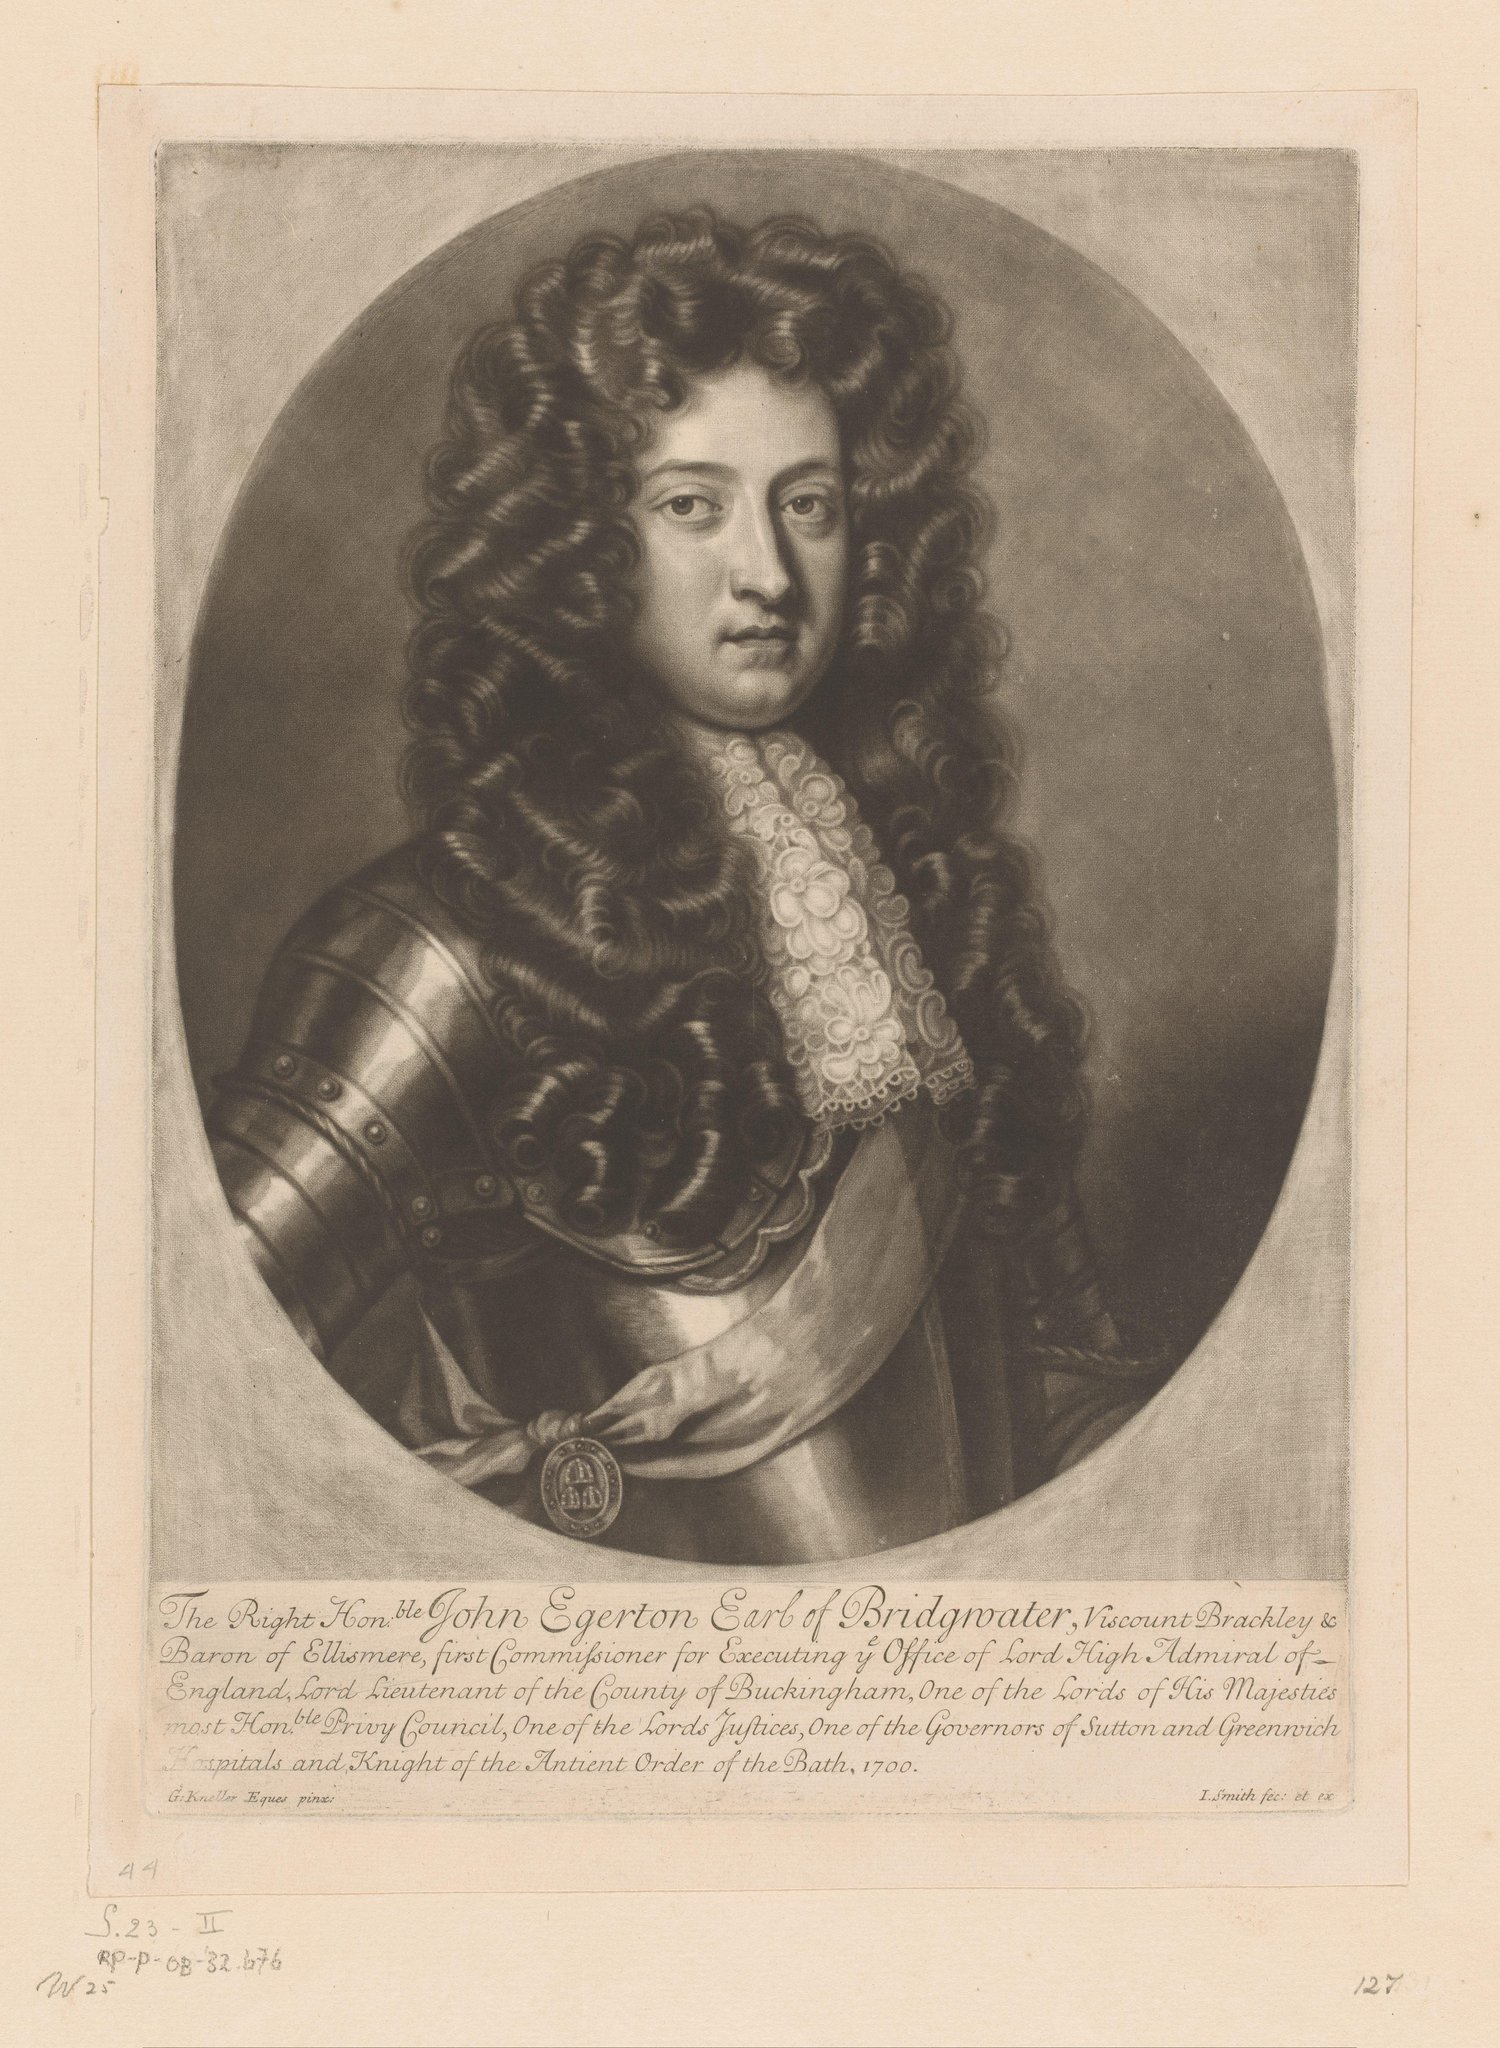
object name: print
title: Portret van John Egerton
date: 1700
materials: paper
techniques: mezzotint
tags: politician, historical persons, politician, e.g. party leader, commander-in-chief, admiral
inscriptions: collector's mark: Lugt 240